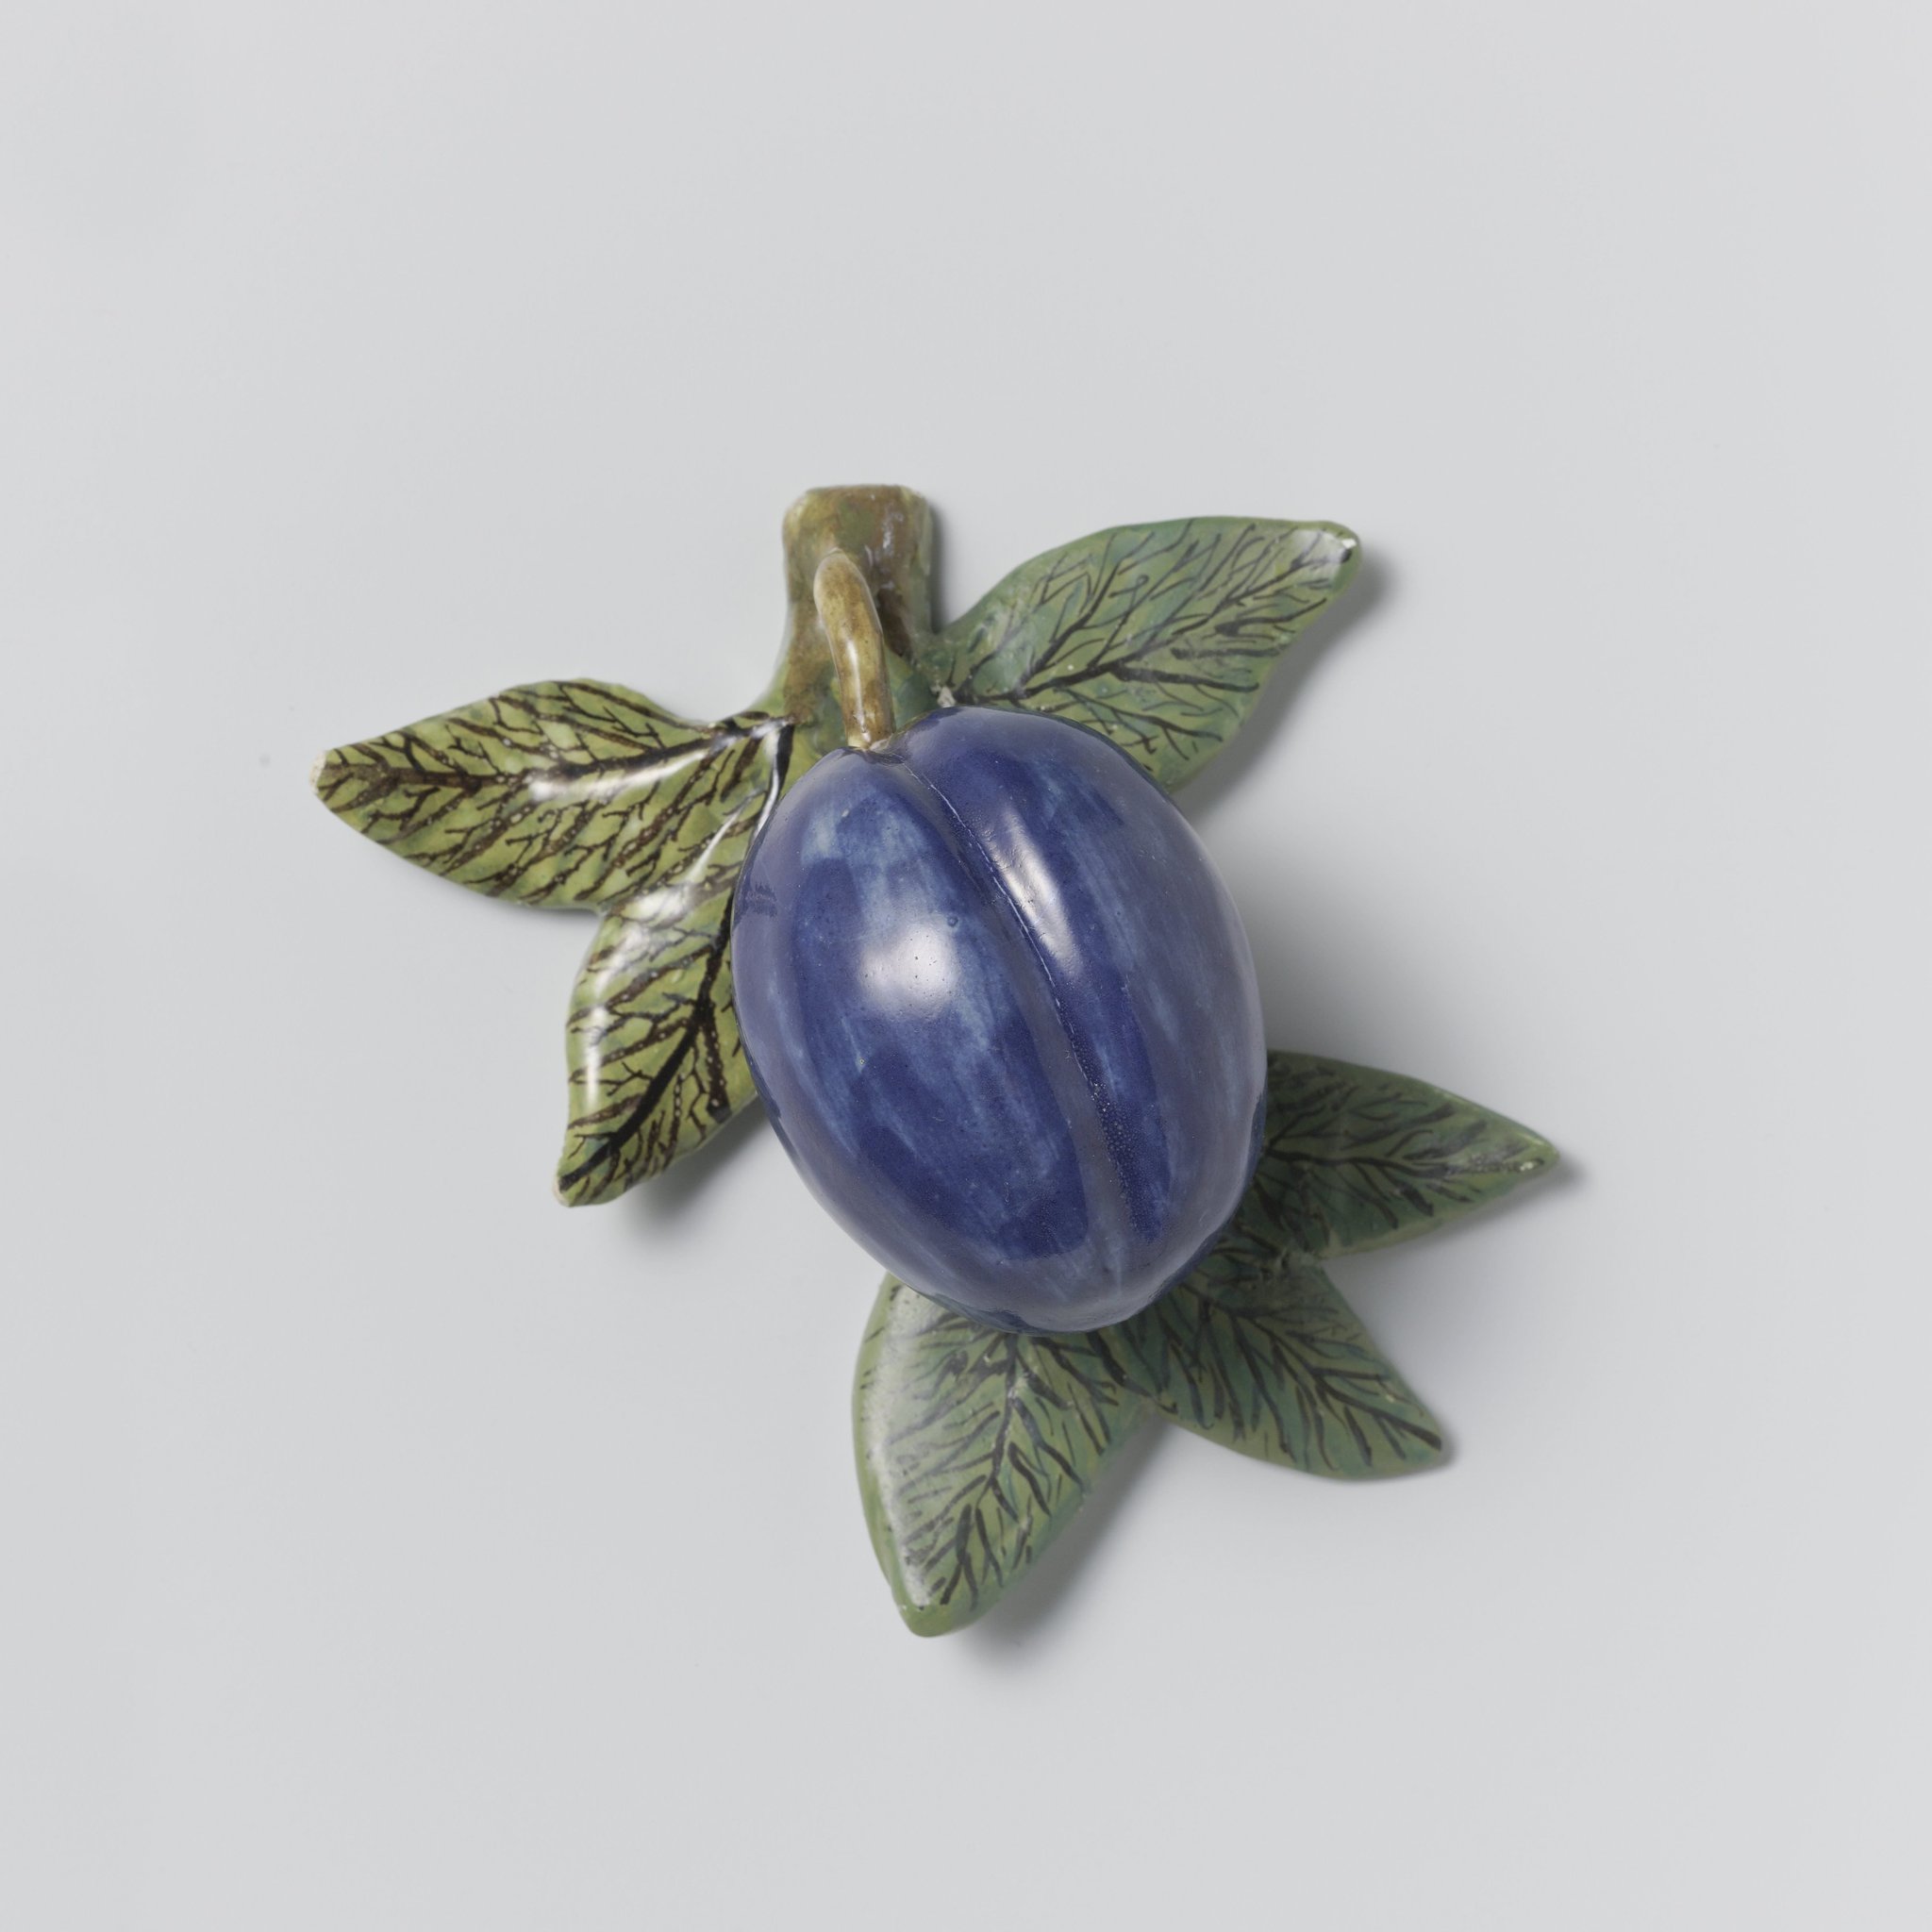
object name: decoratief object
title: Pruim van veelkleurig beschilderde faïence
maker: Anonymous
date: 1750-1775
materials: faience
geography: delft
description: Kunstfruit van faïence, voorstellende een pruim. Veelkleurig beschilderd.